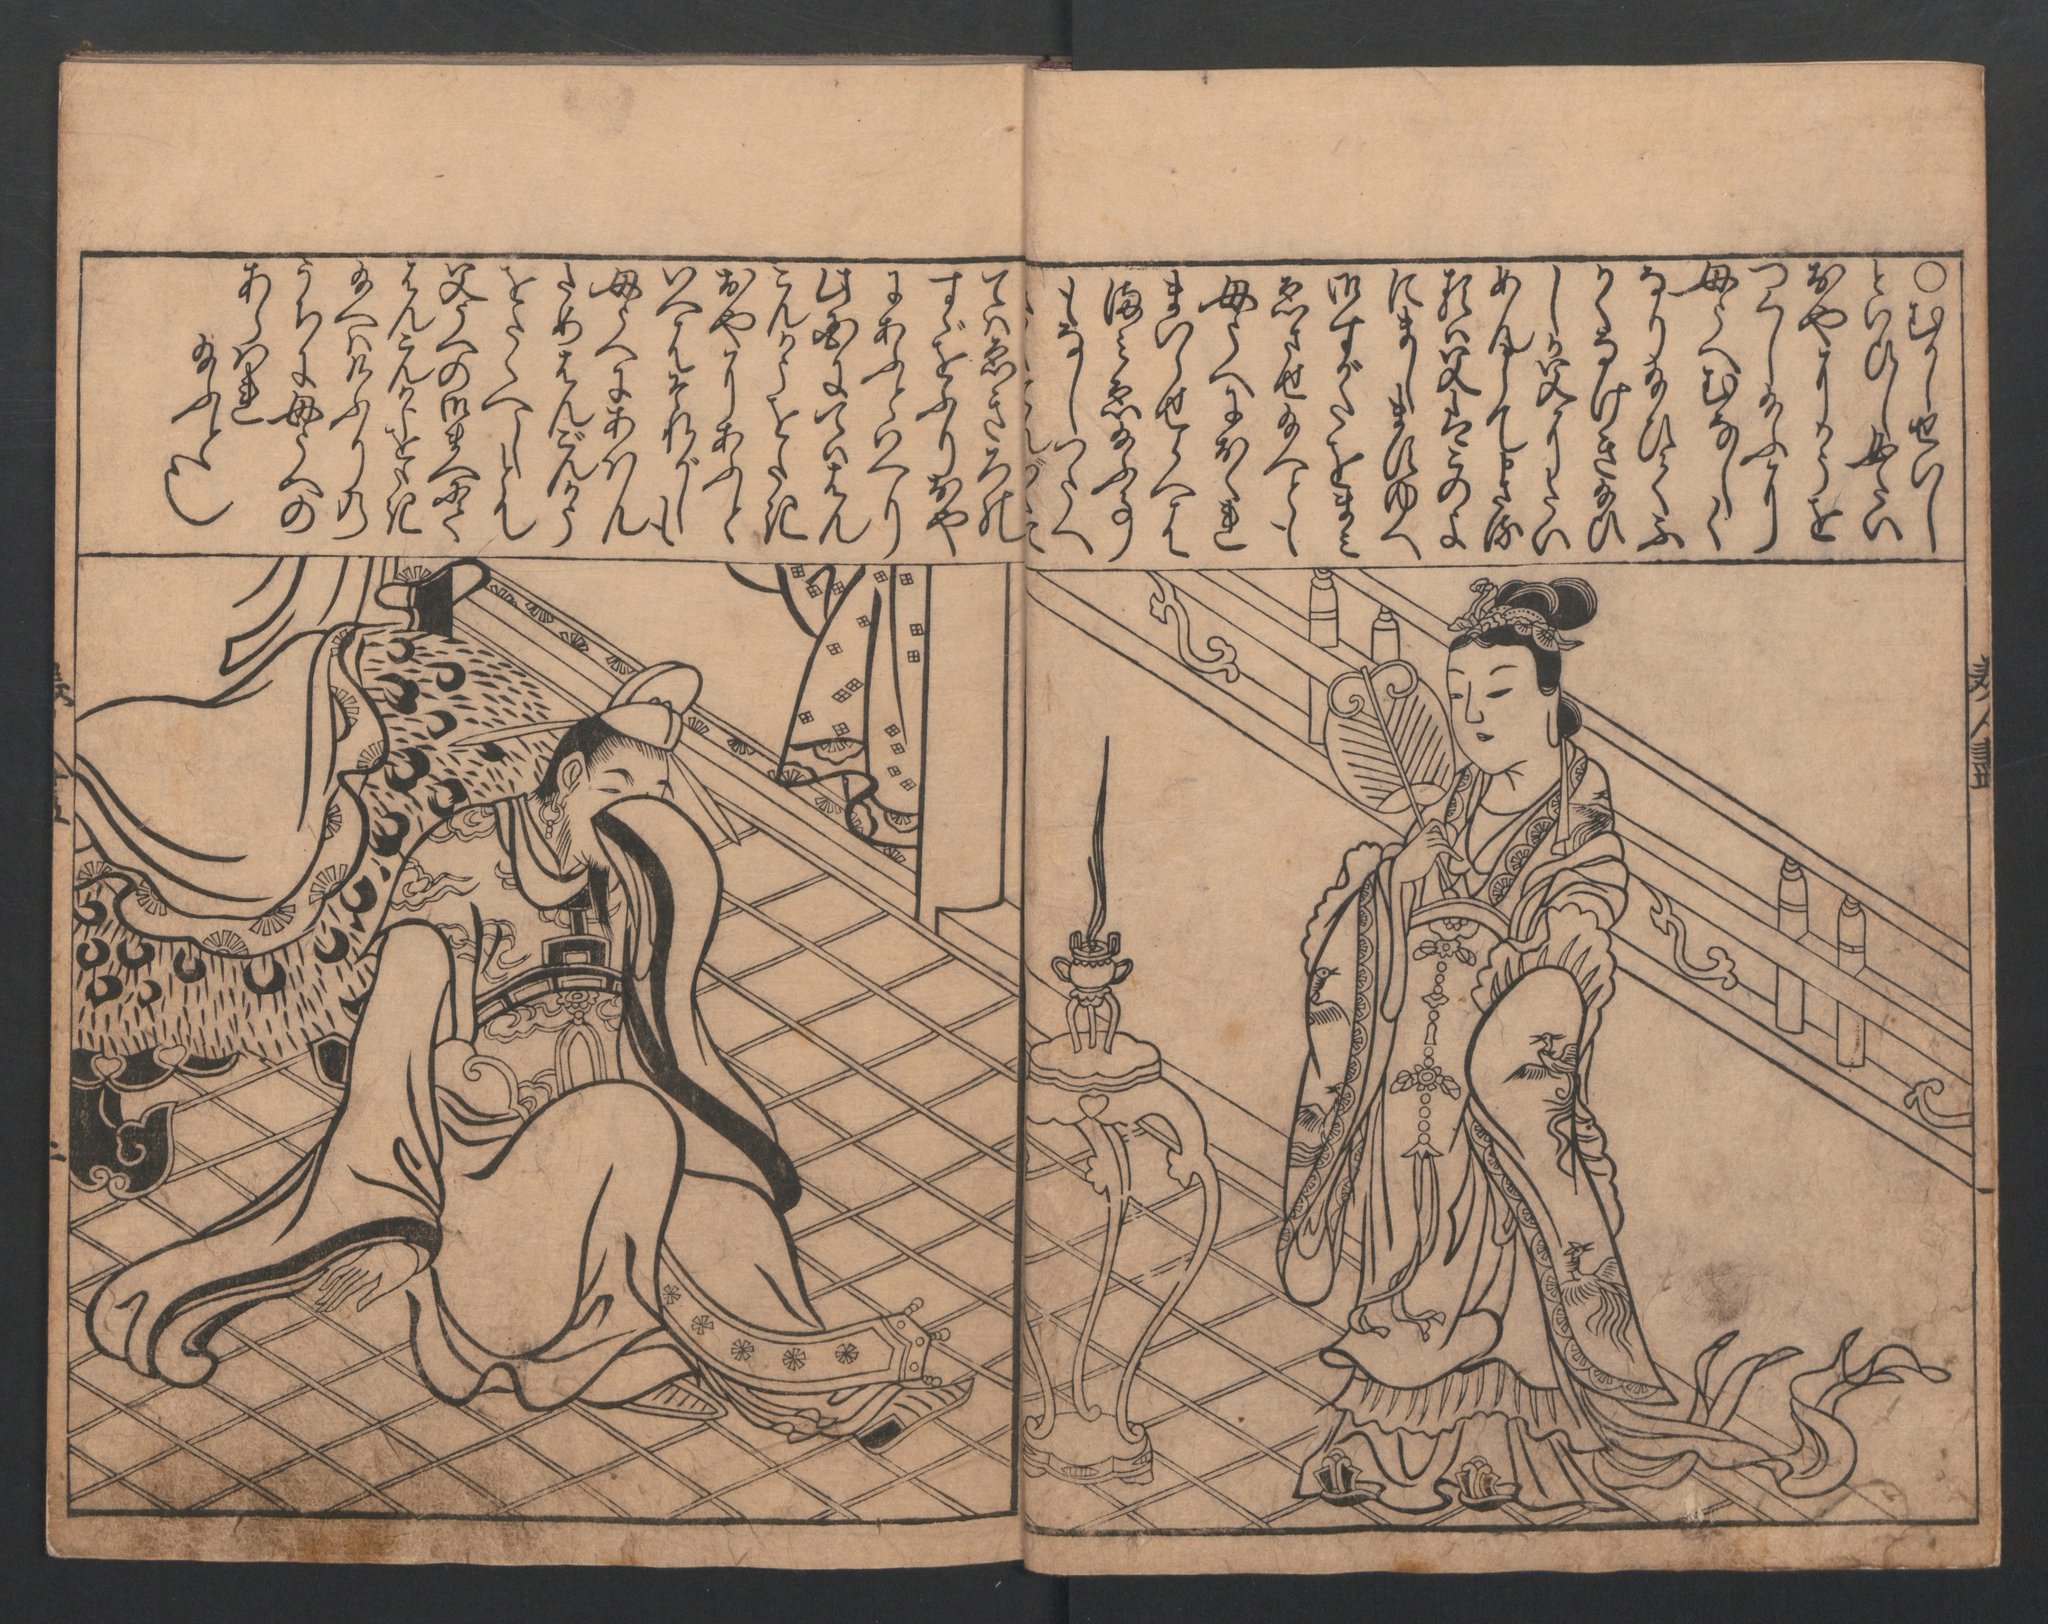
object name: illustrated book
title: Illustrations of Beautiful Women (Bijin e-zukushi) 美人絵づくし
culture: japanese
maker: hishikawa moronobu 菱川師宣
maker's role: artist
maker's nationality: japanese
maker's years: 1618-1694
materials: ink, paper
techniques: woodblock print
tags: women